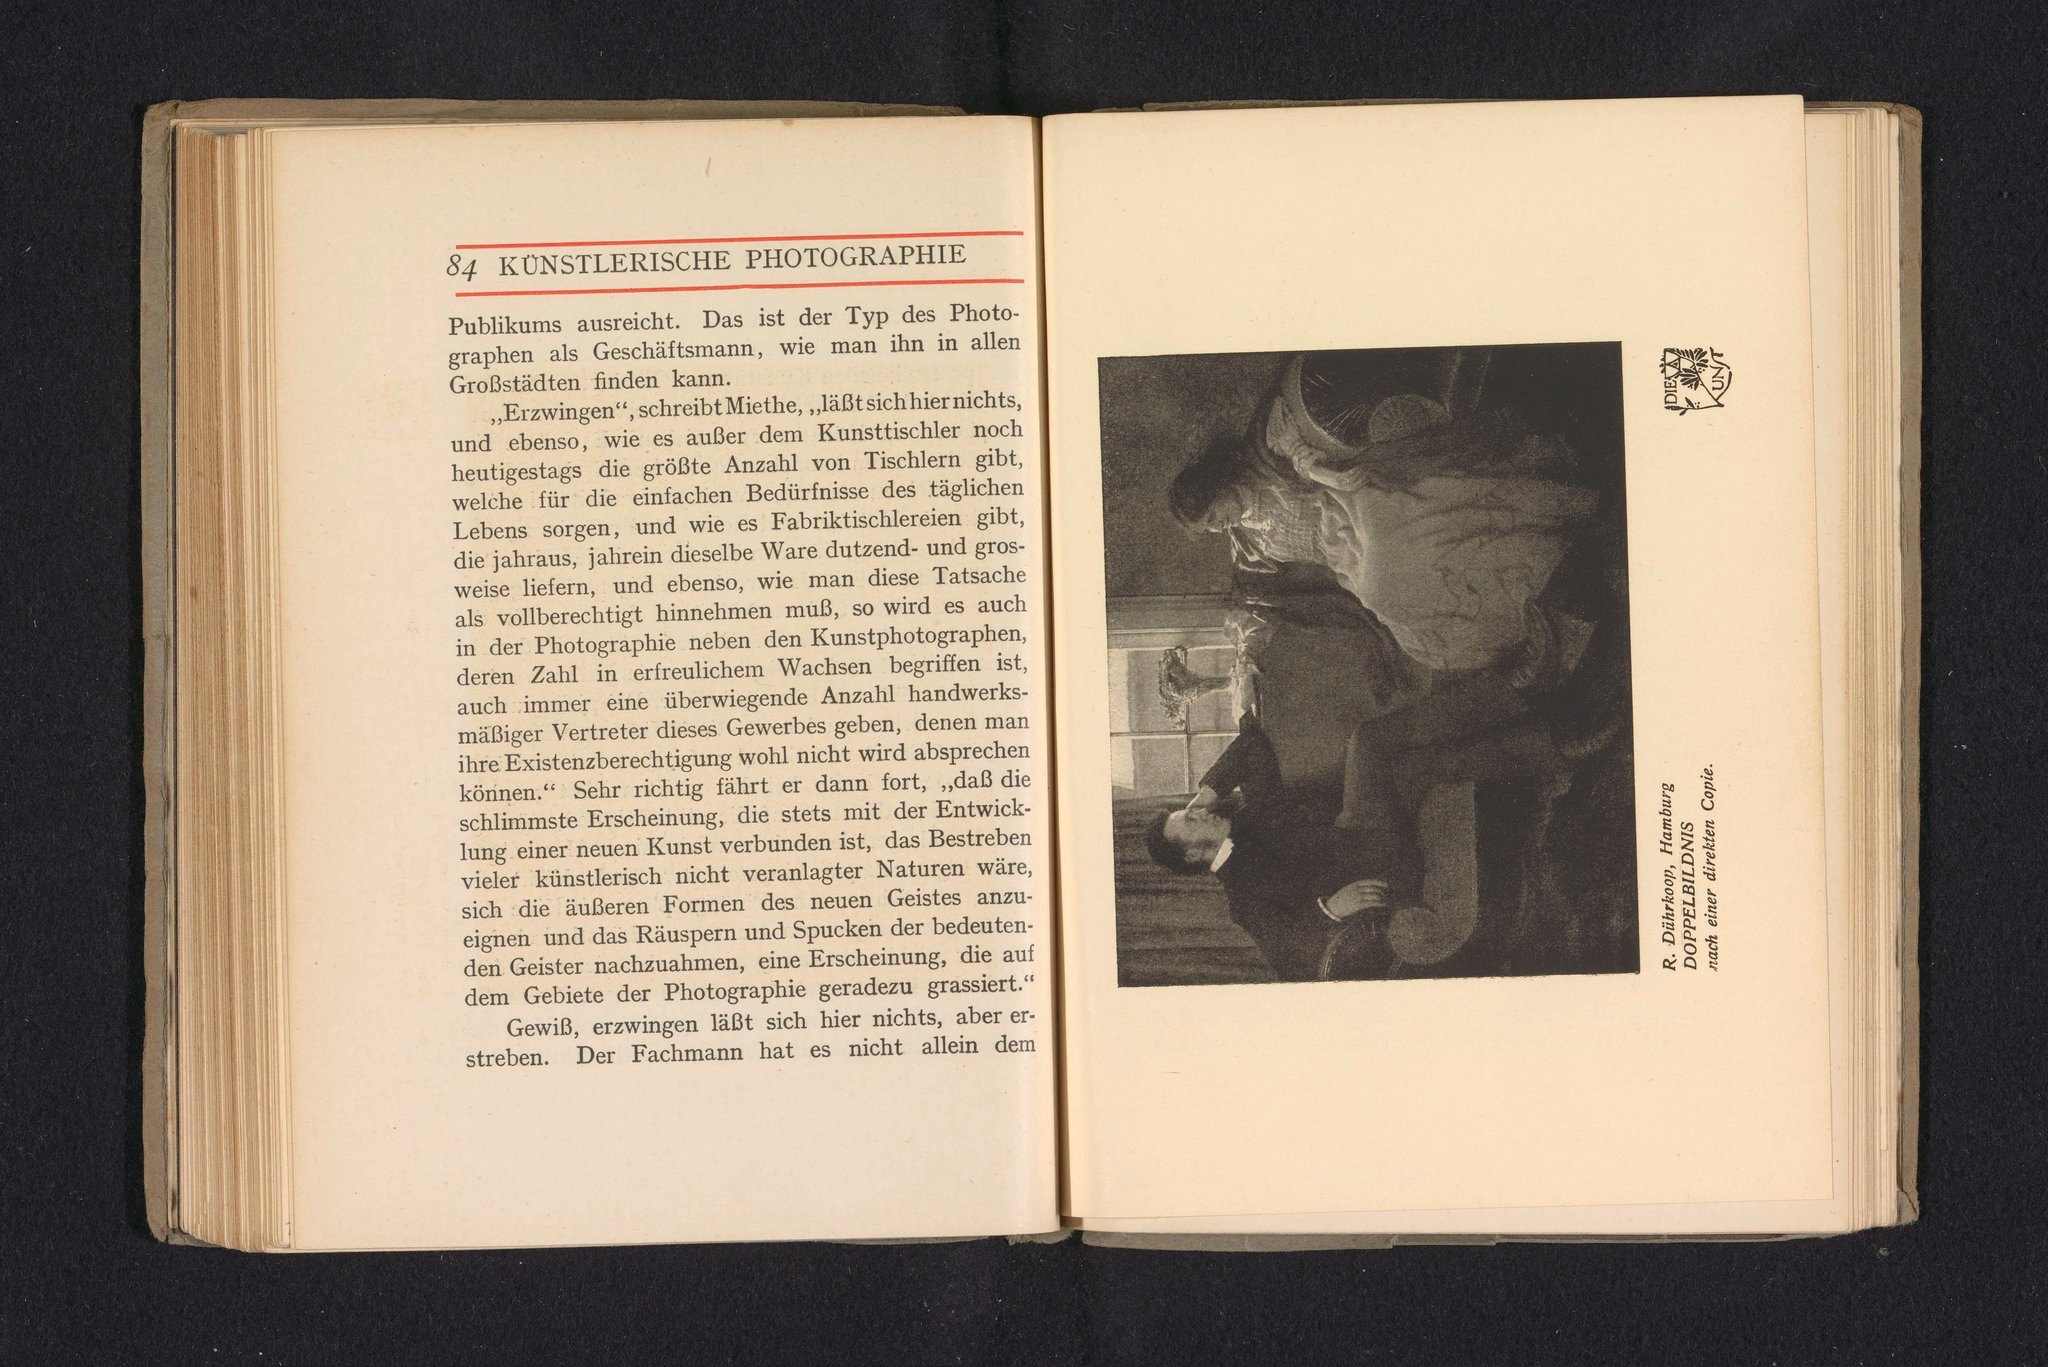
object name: page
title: Doppelbildnis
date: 1880-1907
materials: paper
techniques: autotype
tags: couch, sofa, settee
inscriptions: inscription: ‘nach einer direkten Copie.’